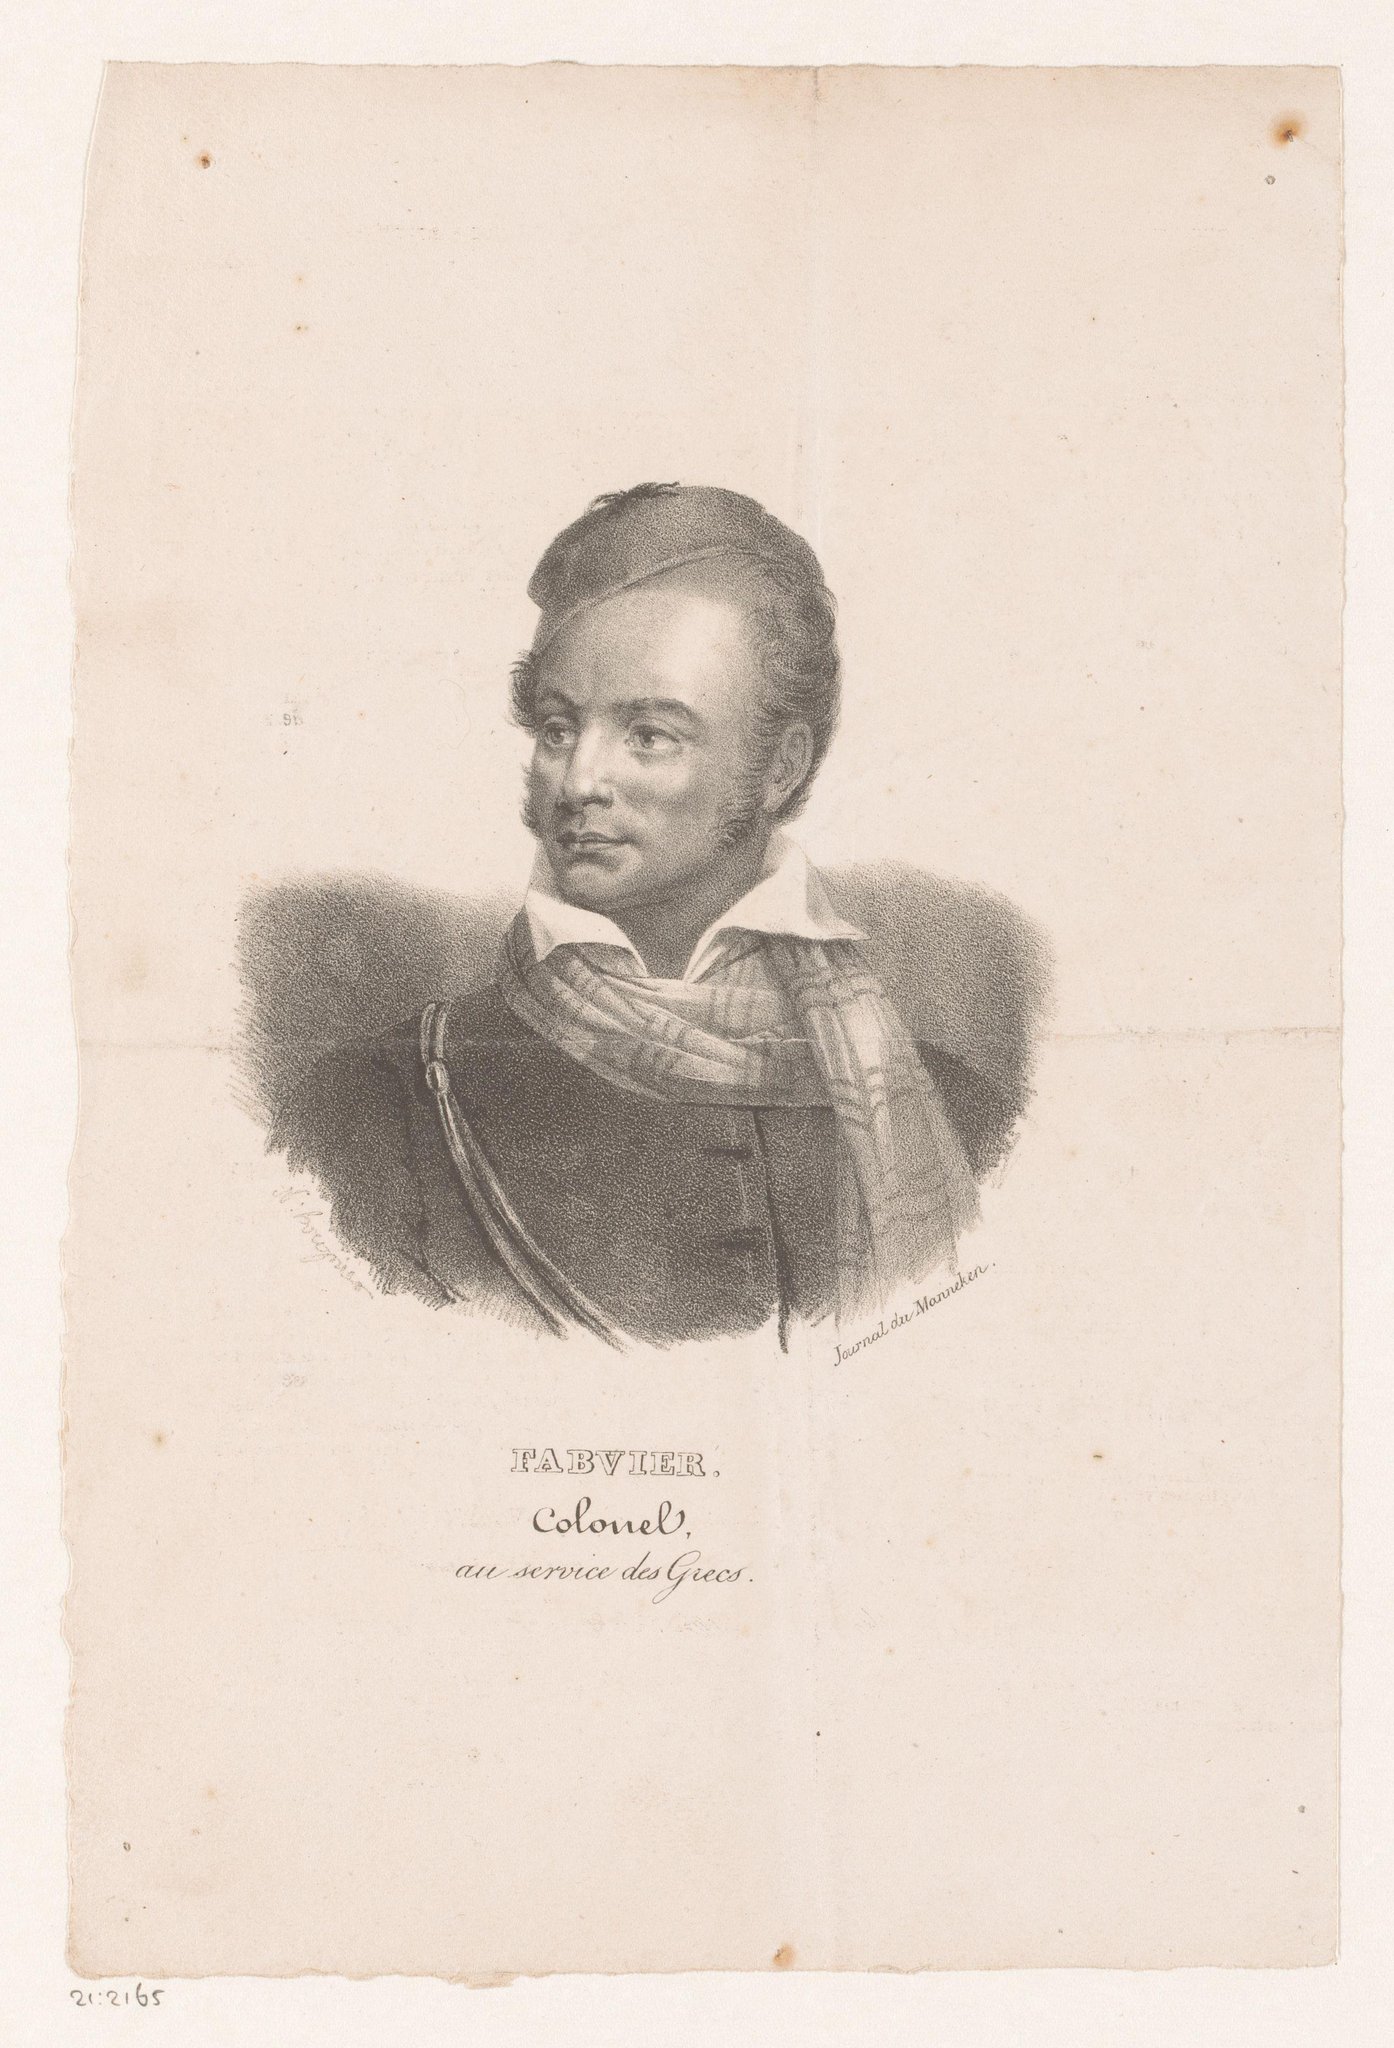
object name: print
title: Portret van Charles Nicolas Fabvier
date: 1827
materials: paper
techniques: lithograph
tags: paris, politician, adult man, historical persons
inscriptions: collector's mark: Lugt 2233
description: Prent verschenen in een uitgave van: Manneken, journal littéraire, industriel, politique, [1827].